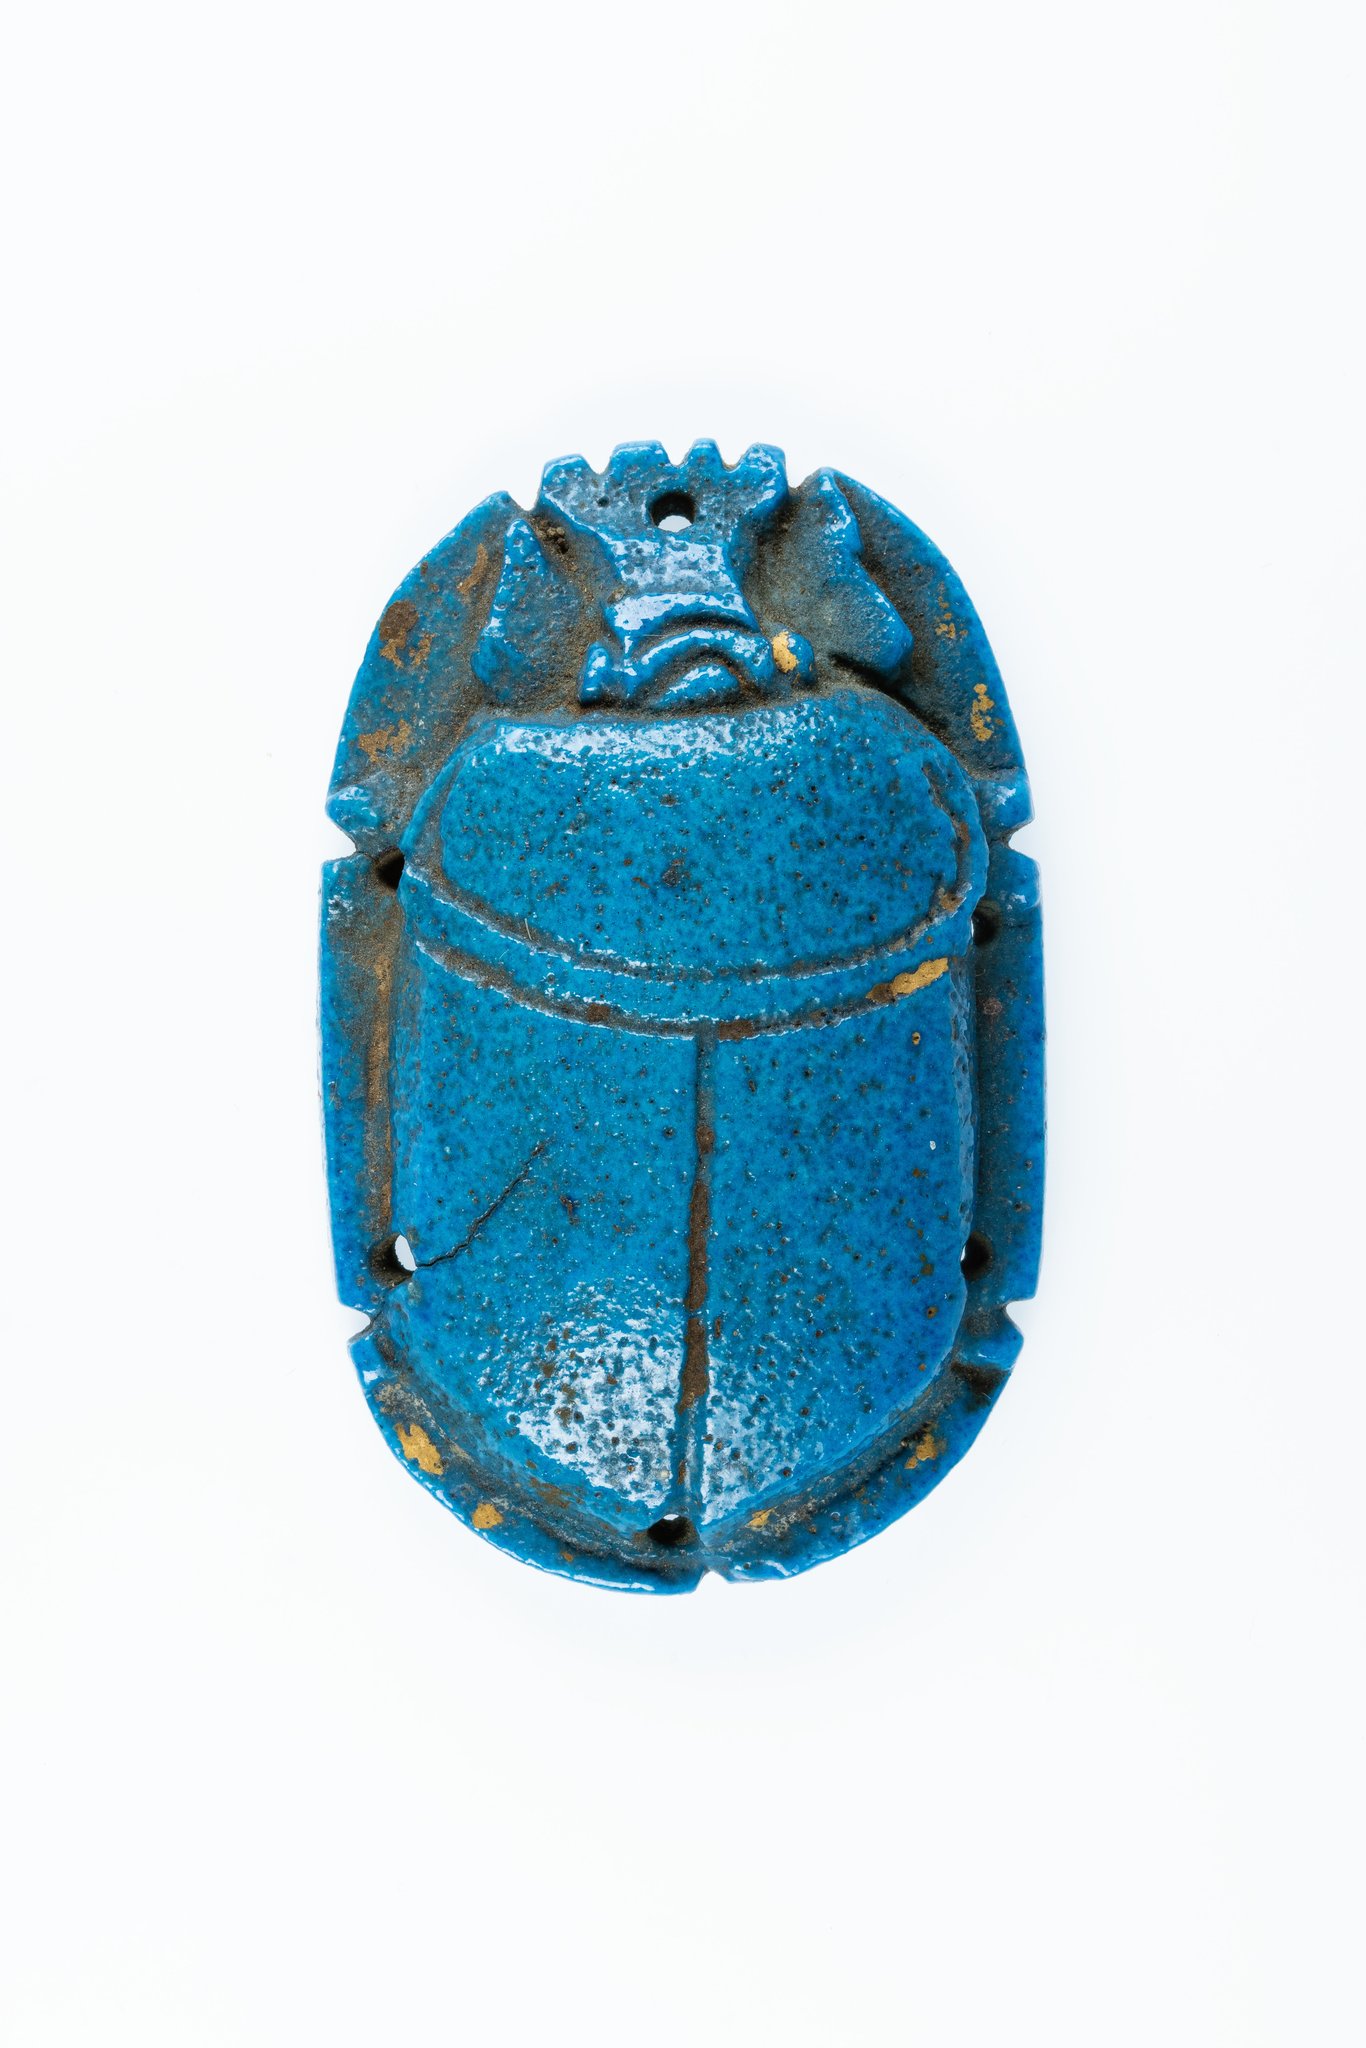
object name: scarab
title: Scarab from mummy wrappings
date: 1070-664 BCE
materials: faience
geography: egypt